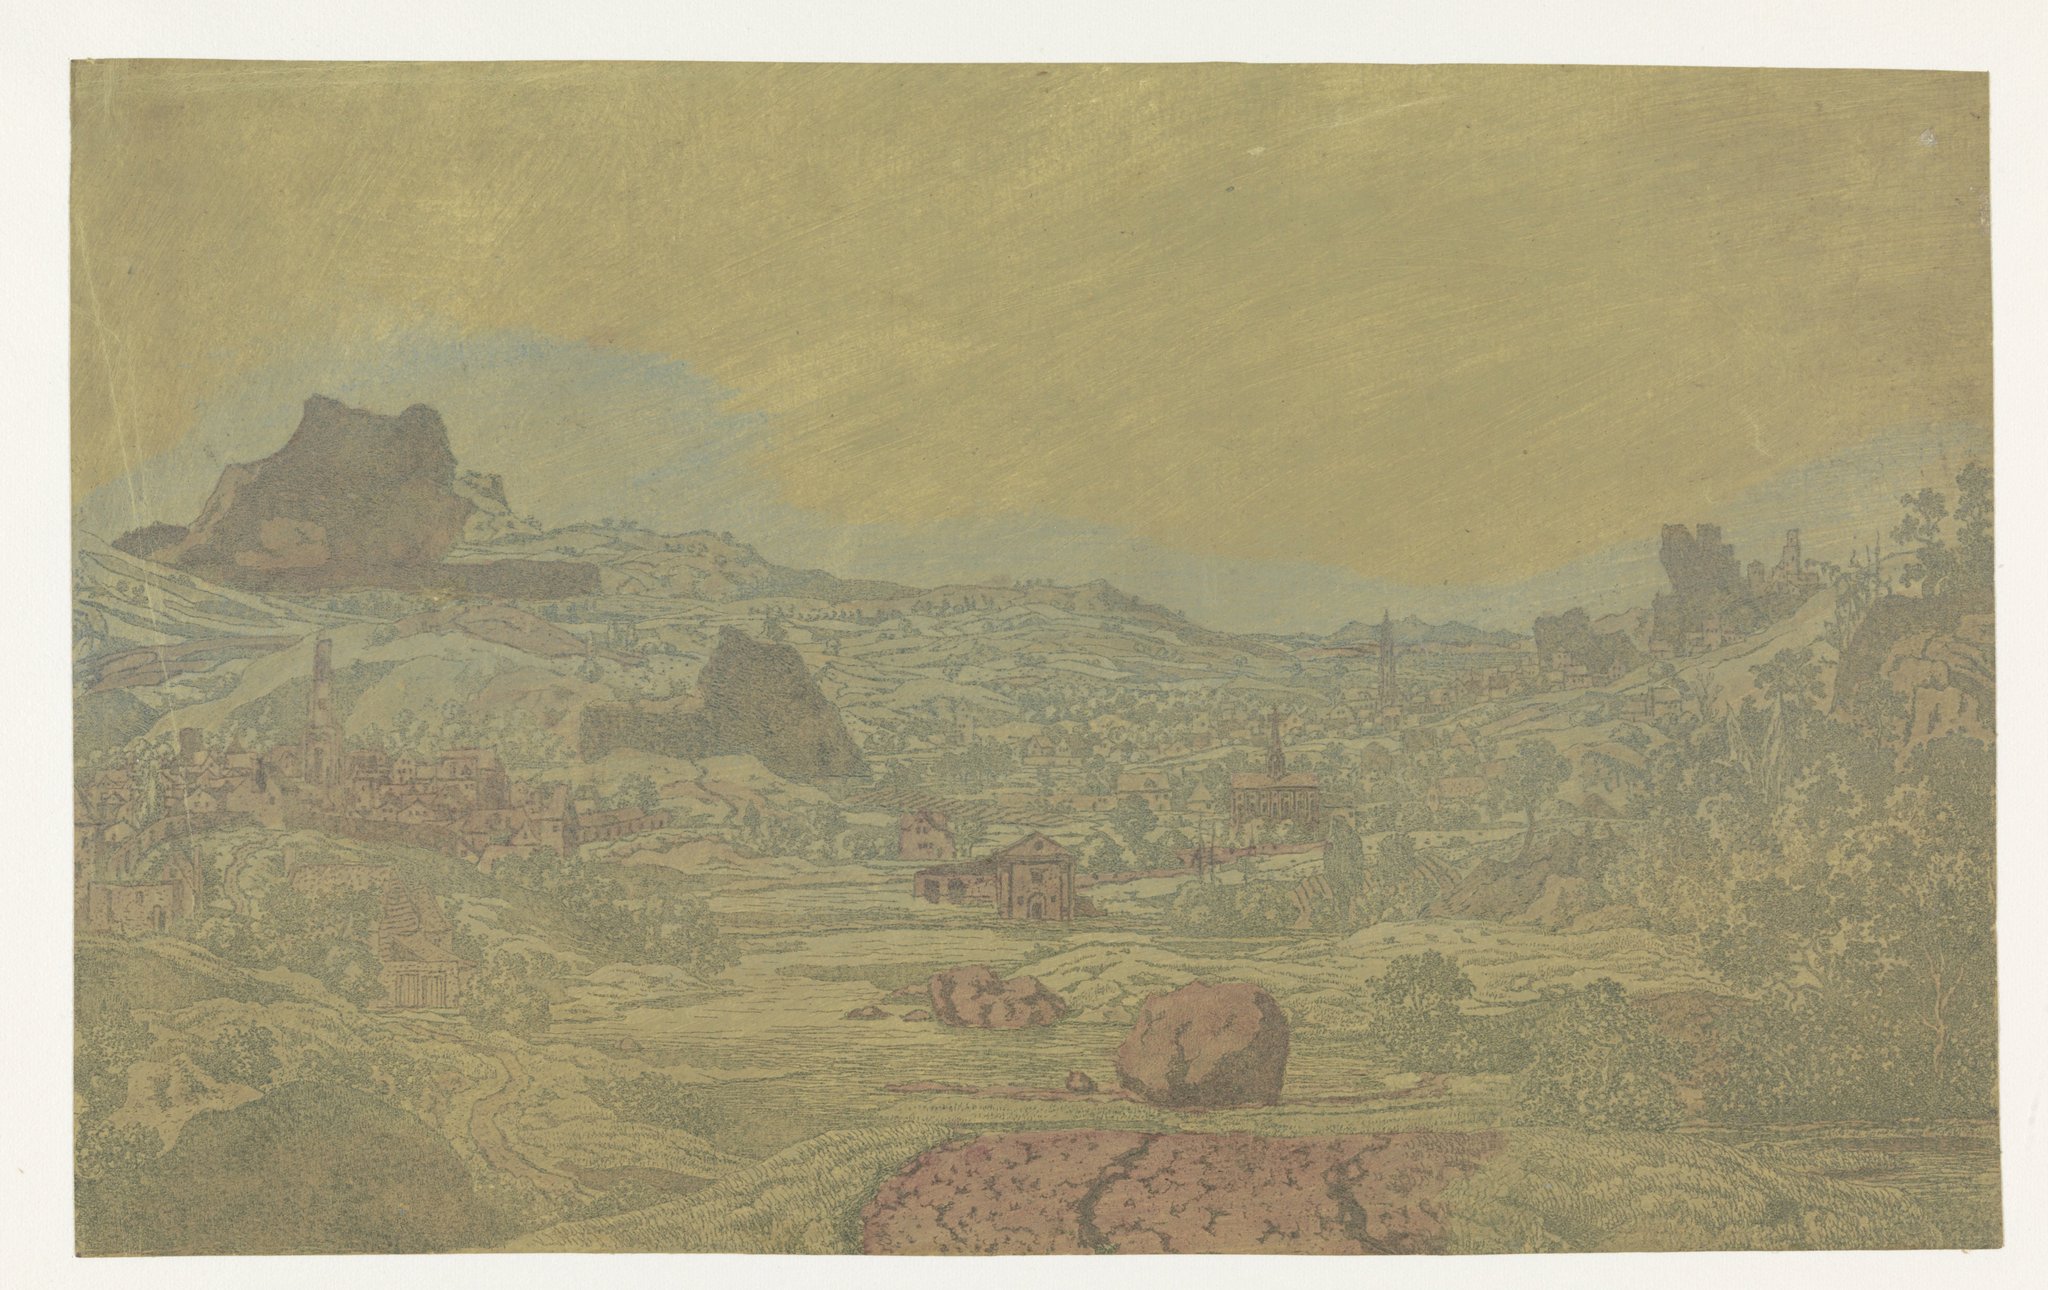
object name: print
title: Valley with a River and a Town with Four Towers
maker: hercules segers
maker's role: draughtsman, painter, print maker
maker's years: 1589-1640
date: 1626-1627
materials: paint, paper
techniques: drypoint, etching, hand coloring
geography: amsterdam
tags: dale, valley, prospect of city, town panorama, silhouette of city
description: The roads, buildings, and rocks in this etching are a claret colour. The same elements in the painting are coloured brown, pink, and red. This makes it plausible that Segers wielded the brush himself in both works.